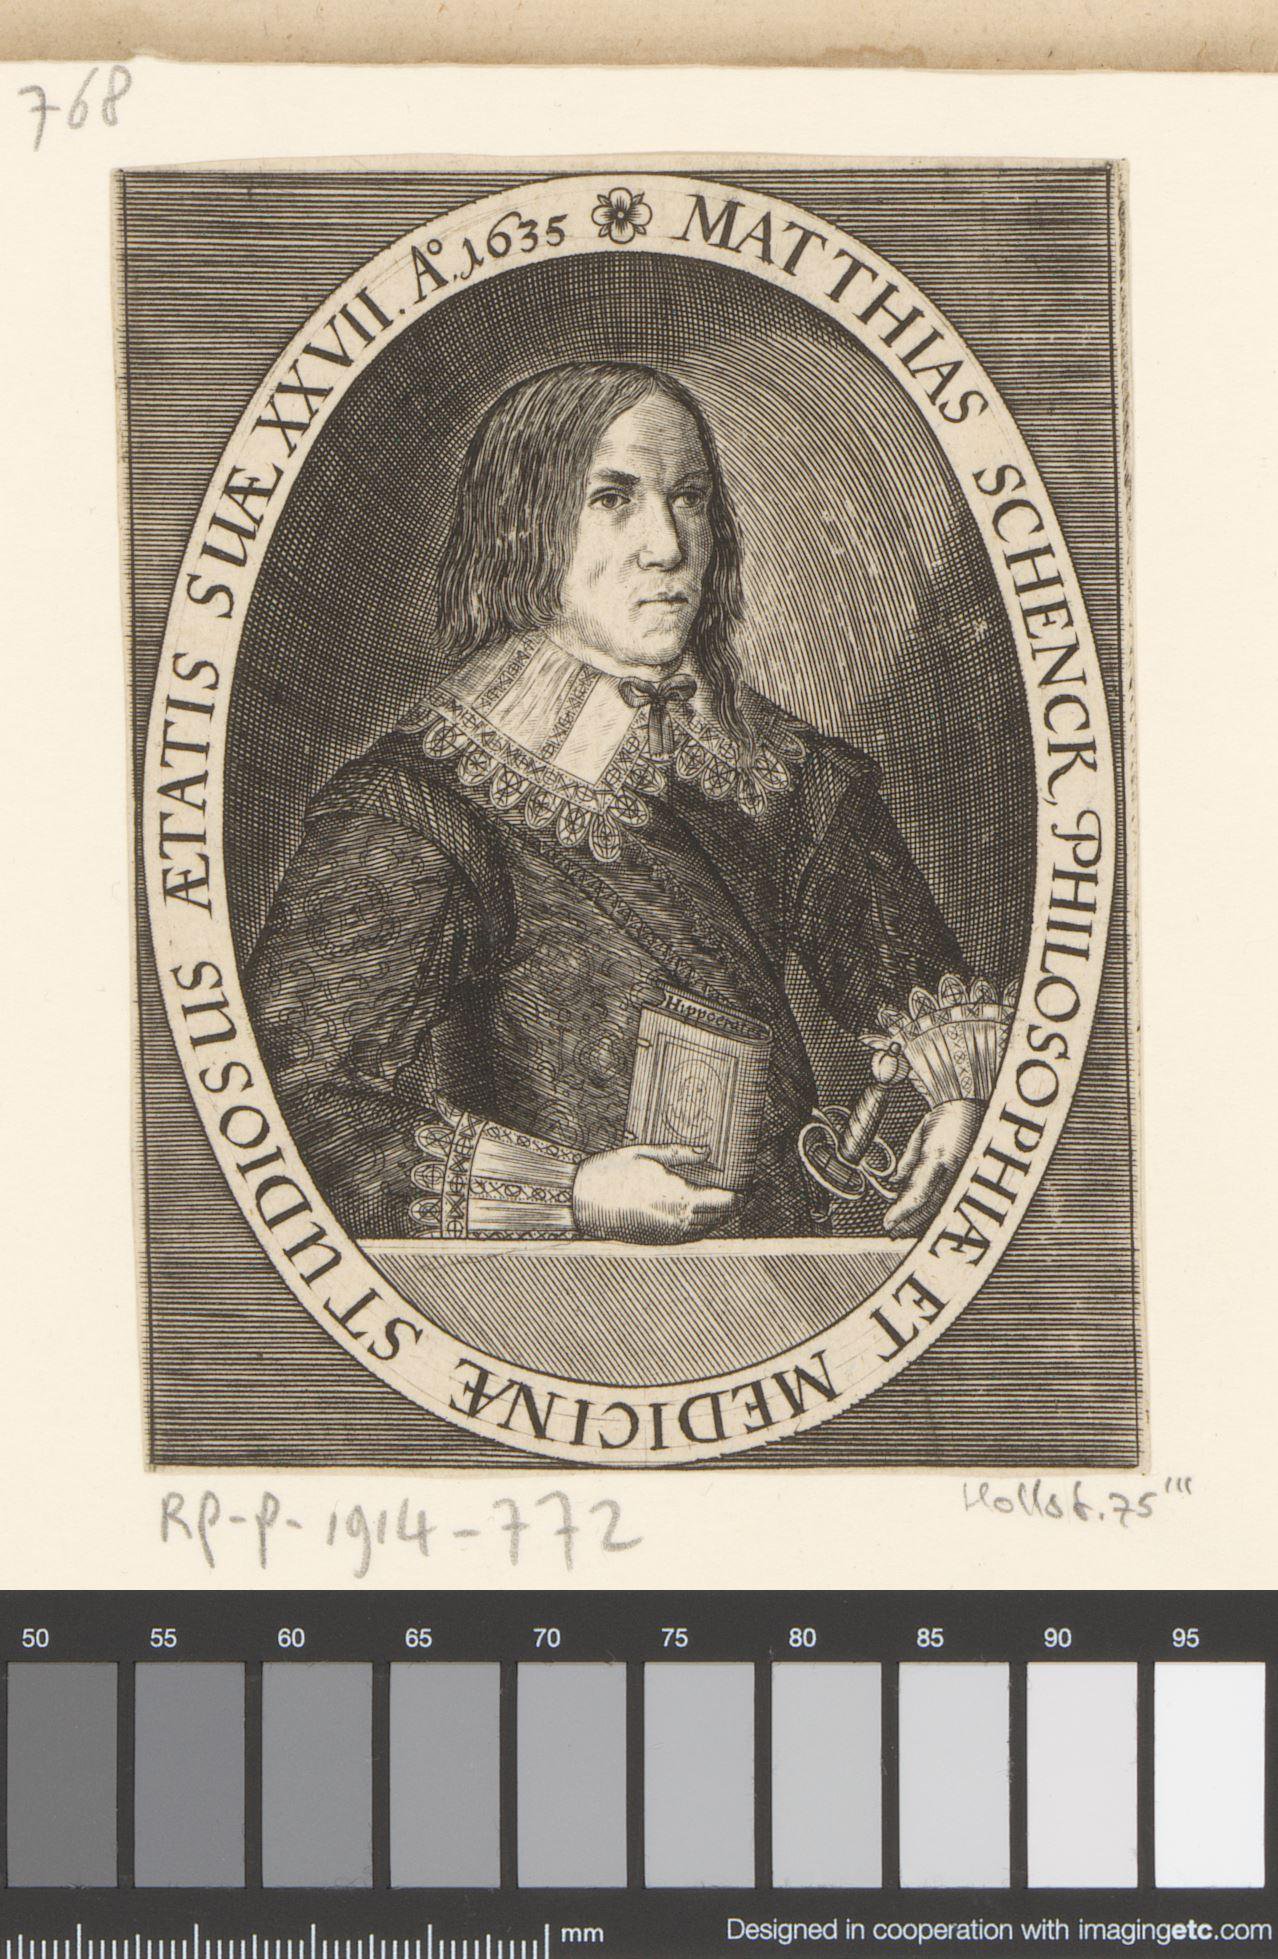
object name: print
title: Portret van Matthias Schenk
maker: johann pfann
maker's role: print maker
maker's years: 1640-1680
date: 1648-1663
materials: paper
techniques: engraving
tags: historical persons, hacking and thrusting weapons: sword, book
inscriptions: collector's mark: Lugt 2228